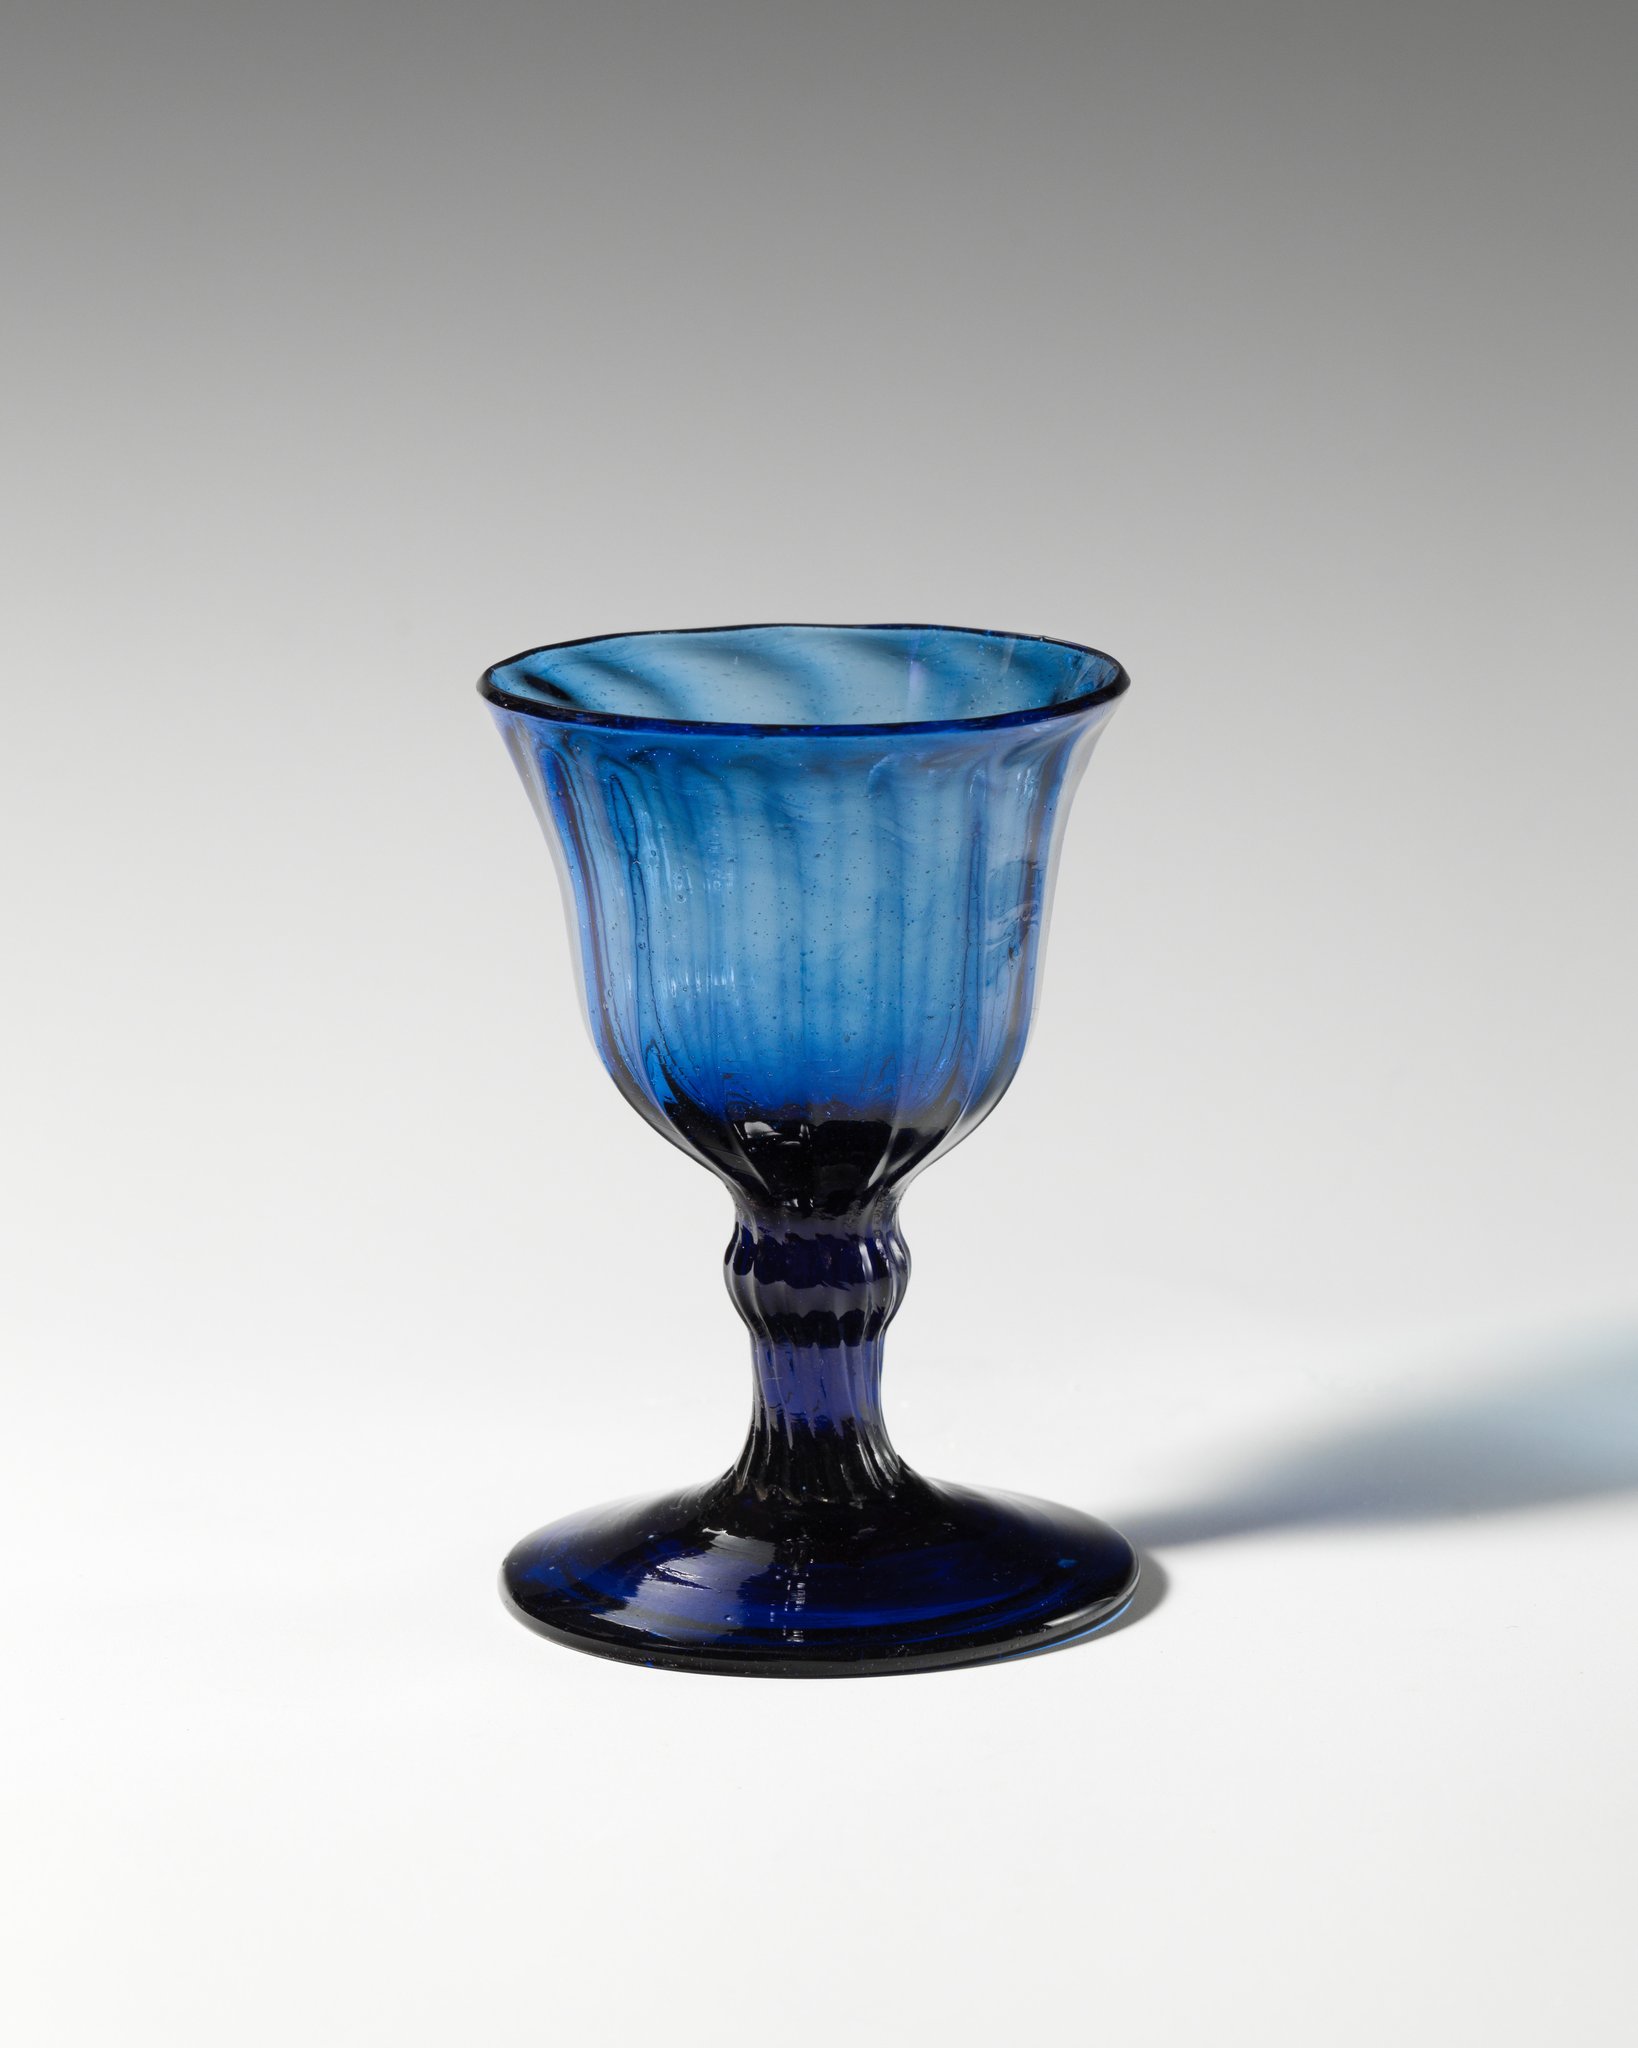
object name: liqueur glass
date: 1750-1800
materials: glass